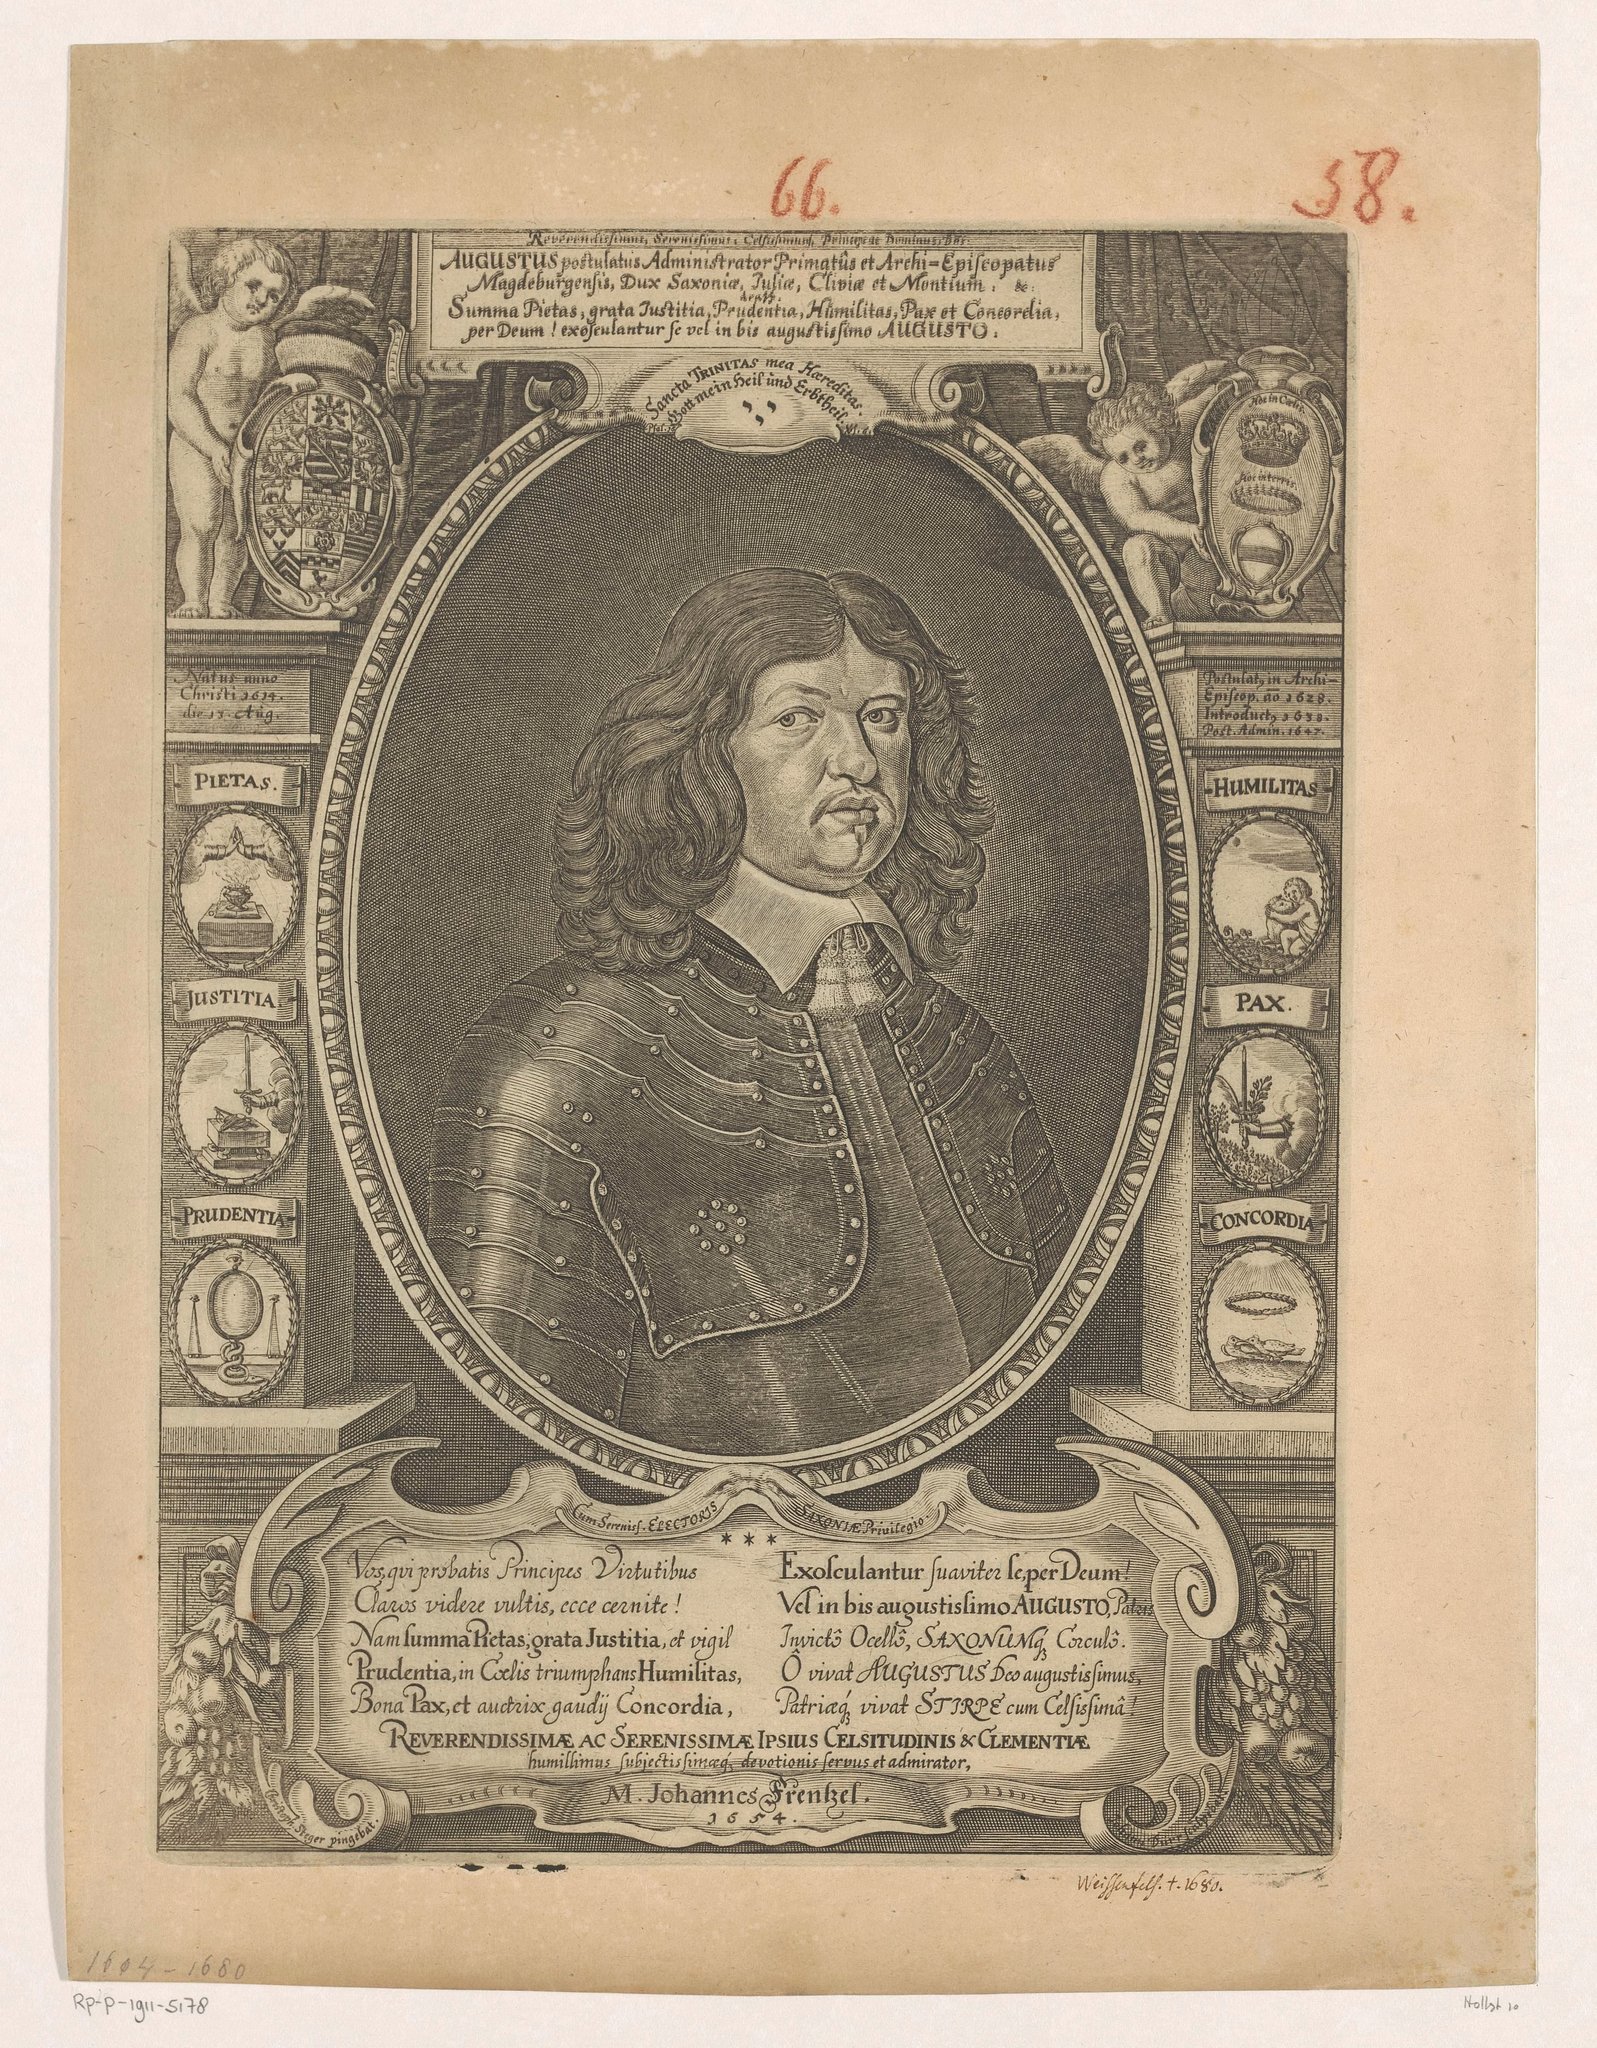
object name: print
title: Portret van August II van Saksen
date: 1654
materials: paper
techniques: engraving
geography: saxony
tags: agreement, unity; 'concordia', 'concordia insuperabile', 'concordia militare', 'concordia di pace', 'unione civile' (ripa), 'pietas'; 'pietà' (ripa), justice, 'justitia'; 'giustitia divina' (ripa) ~ one of the four cardinal virtues, prudence, 'prudentia'; 'prudenza' (ripa) ~ one of the four cardinal virtues, symbols, allegories of peace, 'pax'; 'pace' (ripa), ornament ~ medallion, historical persons, ornament ~ cartouche, humility; 'humiltà' (ripa), armorial bearing, heraldry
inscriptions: collector's mark: Lugt 2228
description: Portret met daaromheen acht kleine medaillons, waarvan zes met motto (piëtas, justitia, prudentia, humilitas, pax, concordia) en twee met wapenschilden. Lofdicht in cartouche onder het portret.